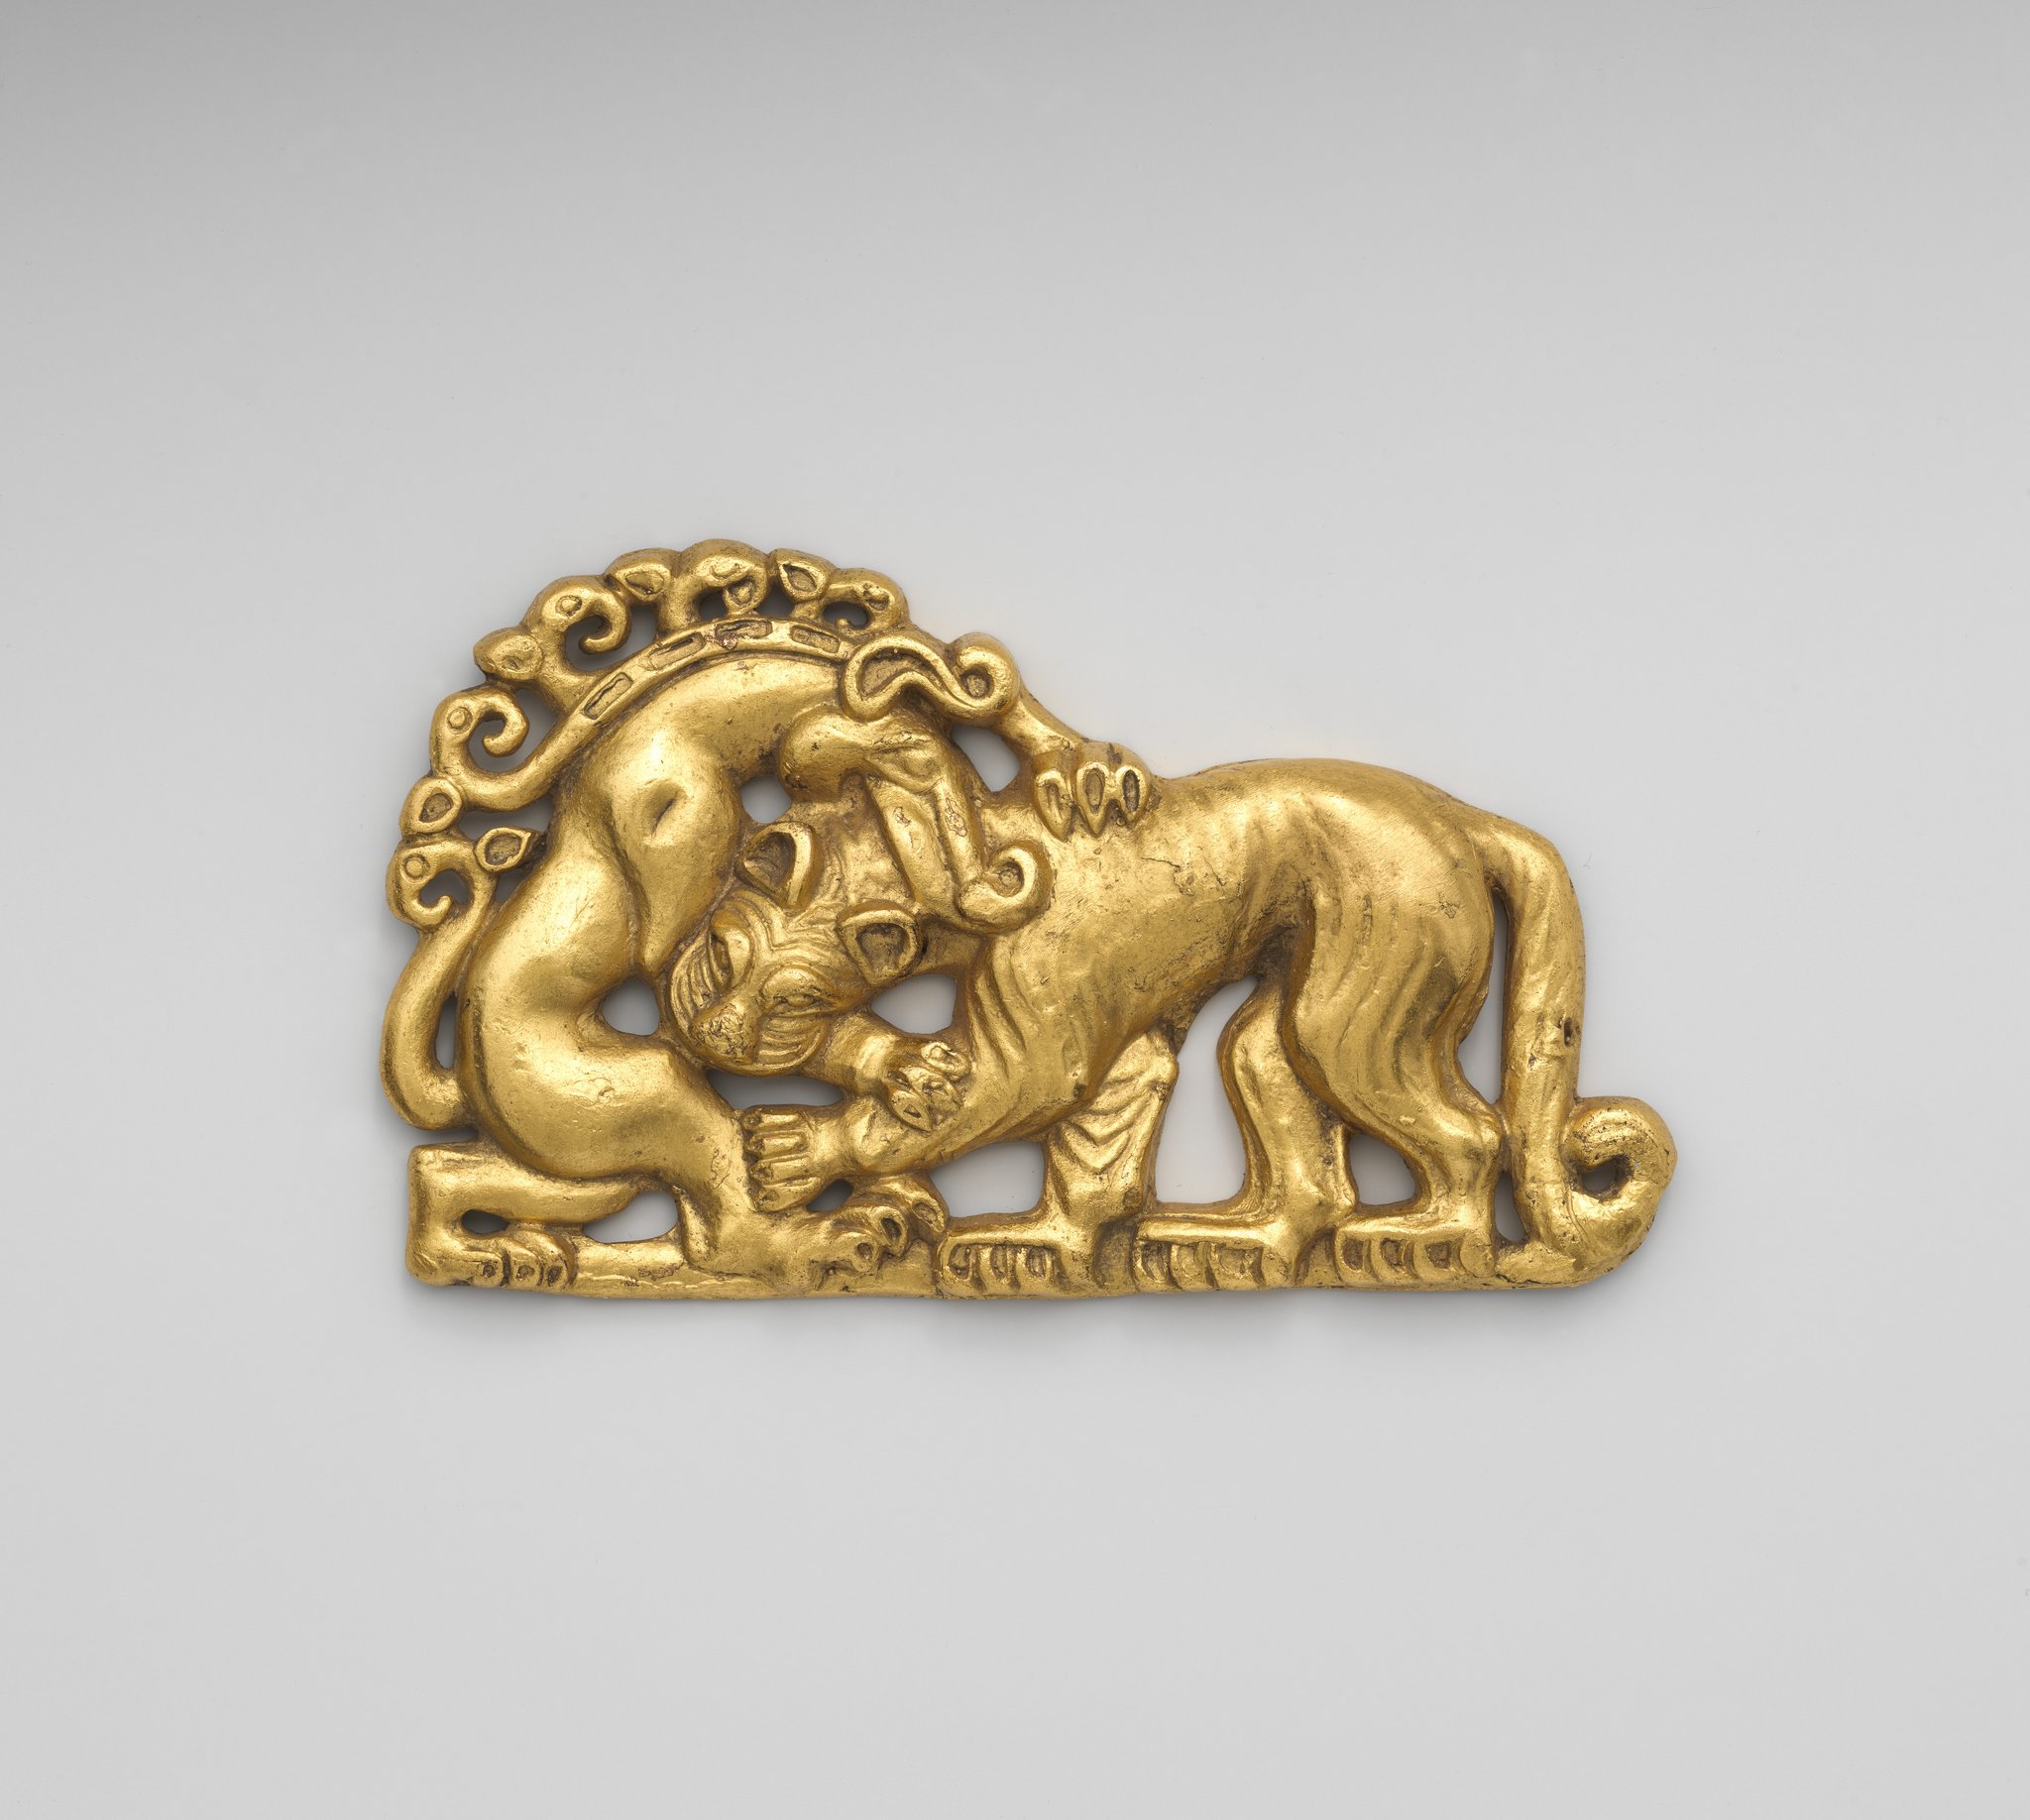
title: Reproduction of a Scythian plaque with animal combat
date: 1801-1900